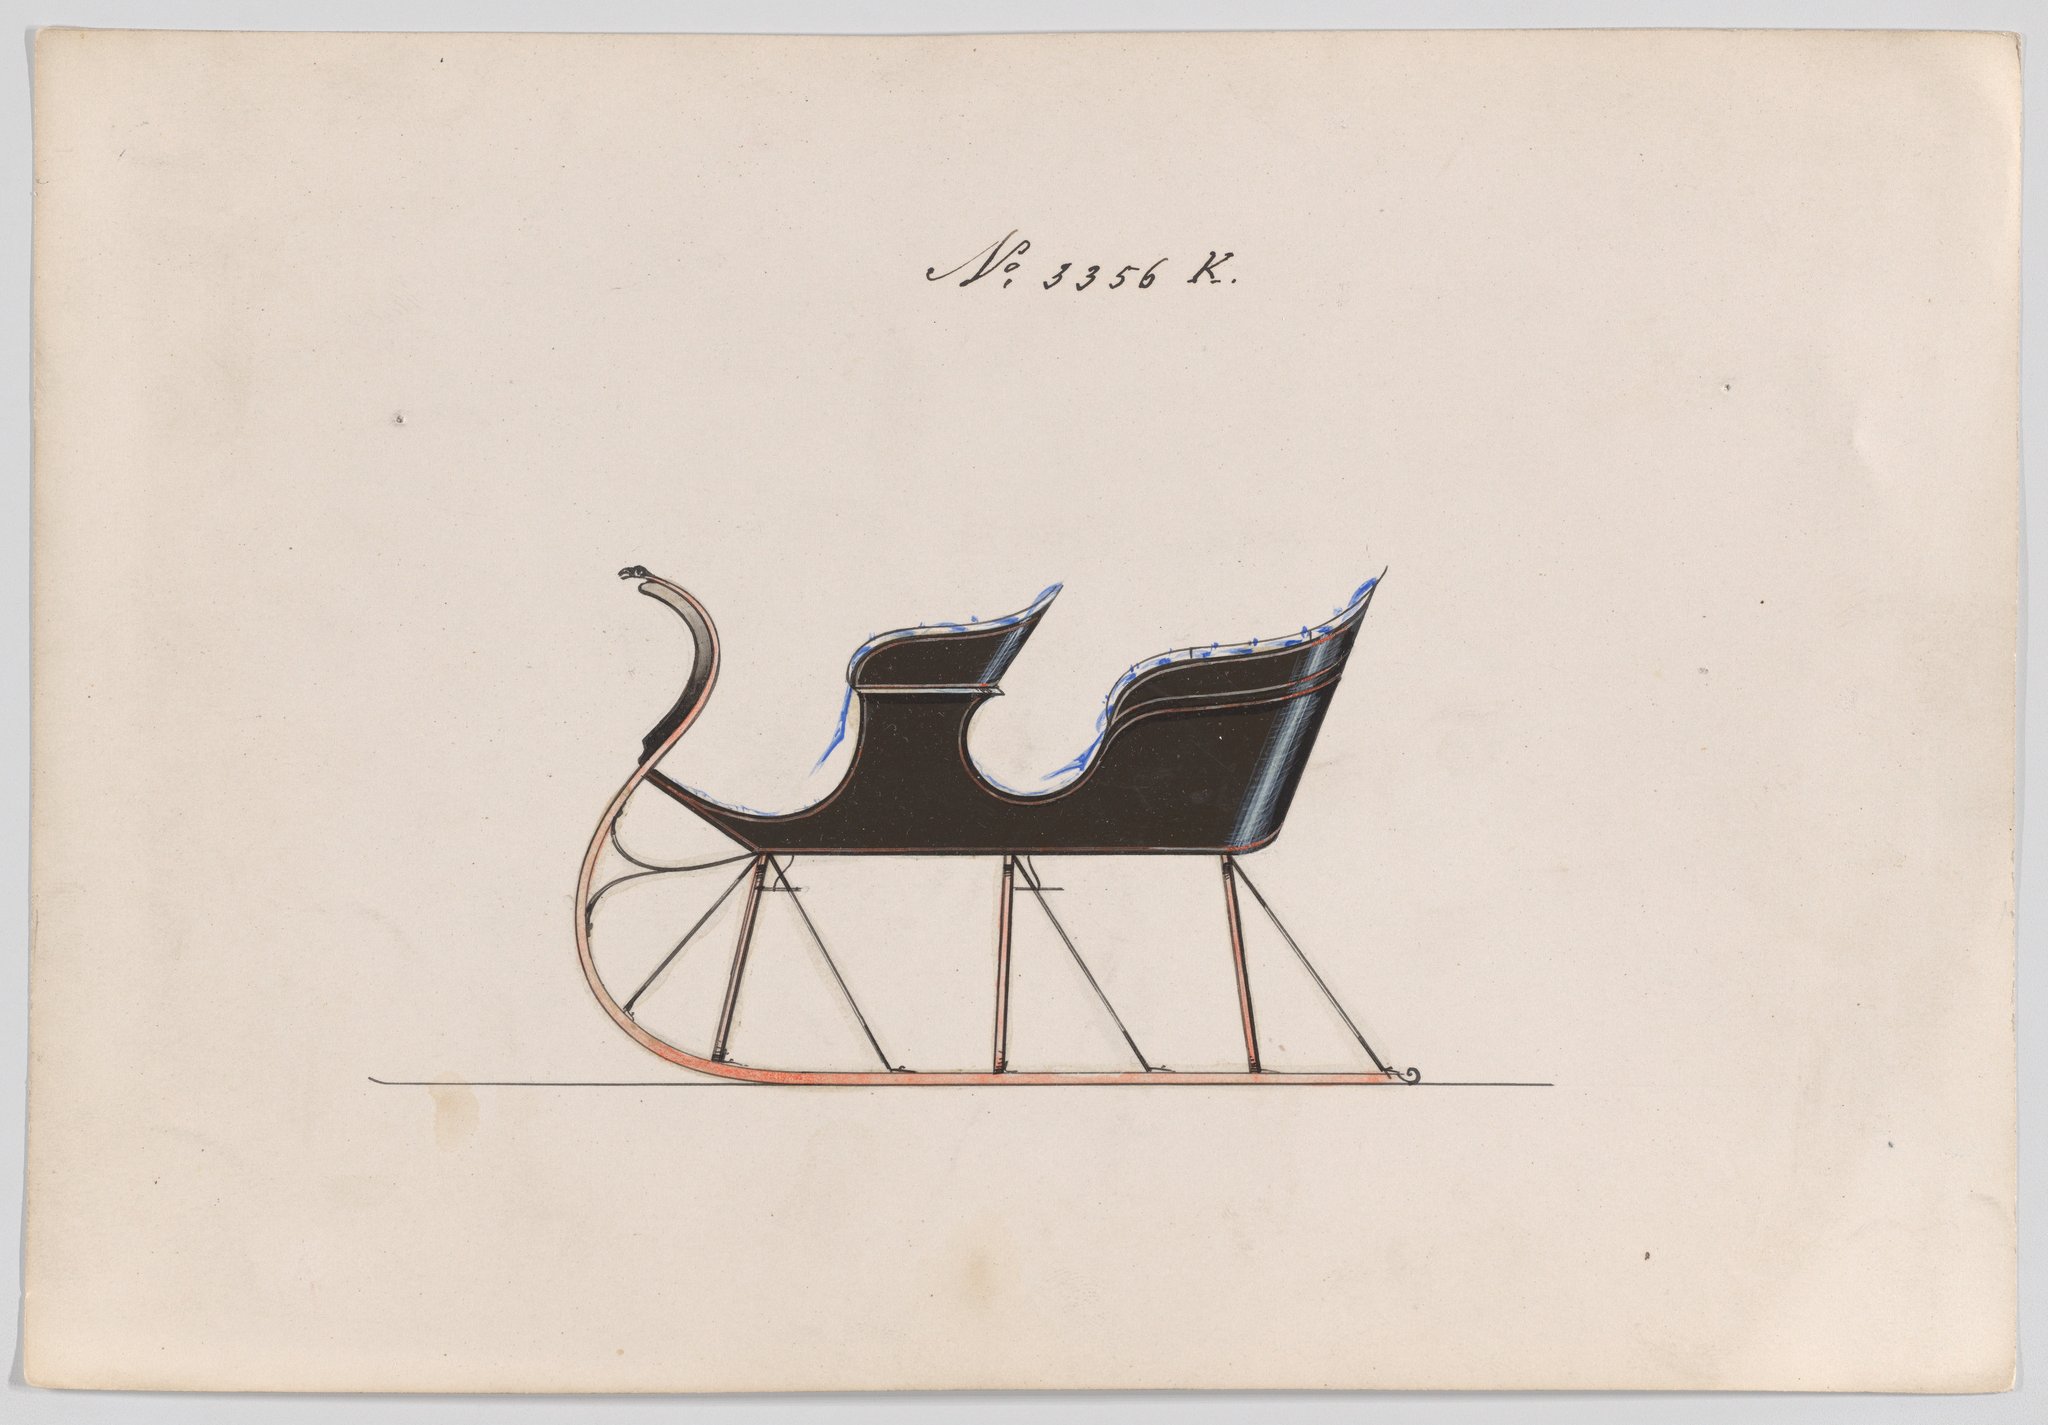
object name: drawing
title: Sleigh #3356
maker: brewster & co.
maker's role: manufacturer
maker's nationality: american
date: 1877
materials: gouache, gum arabic, ink, watercolor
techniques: pen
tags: sleighs